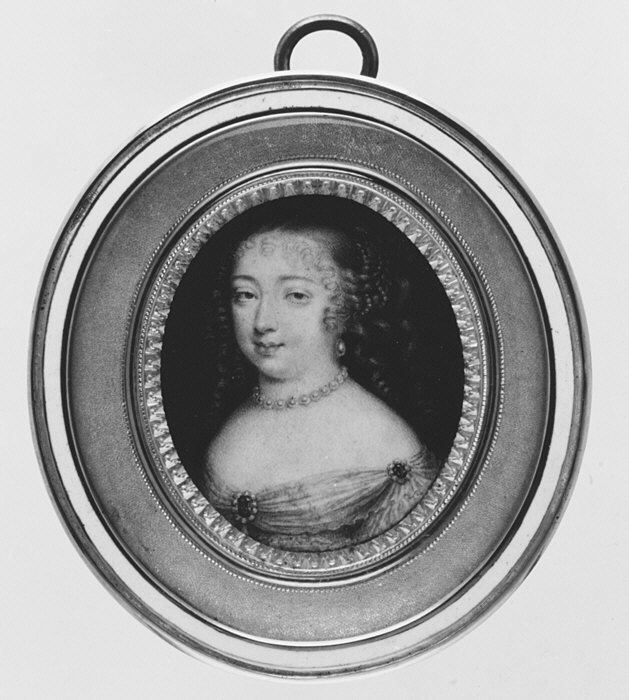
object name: painting, miniature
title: Portrait of a Woman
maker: jean petitot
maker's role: artist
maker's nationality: swiss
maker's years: 1607-1691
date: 1627-1691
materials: parchment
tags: portraits,women